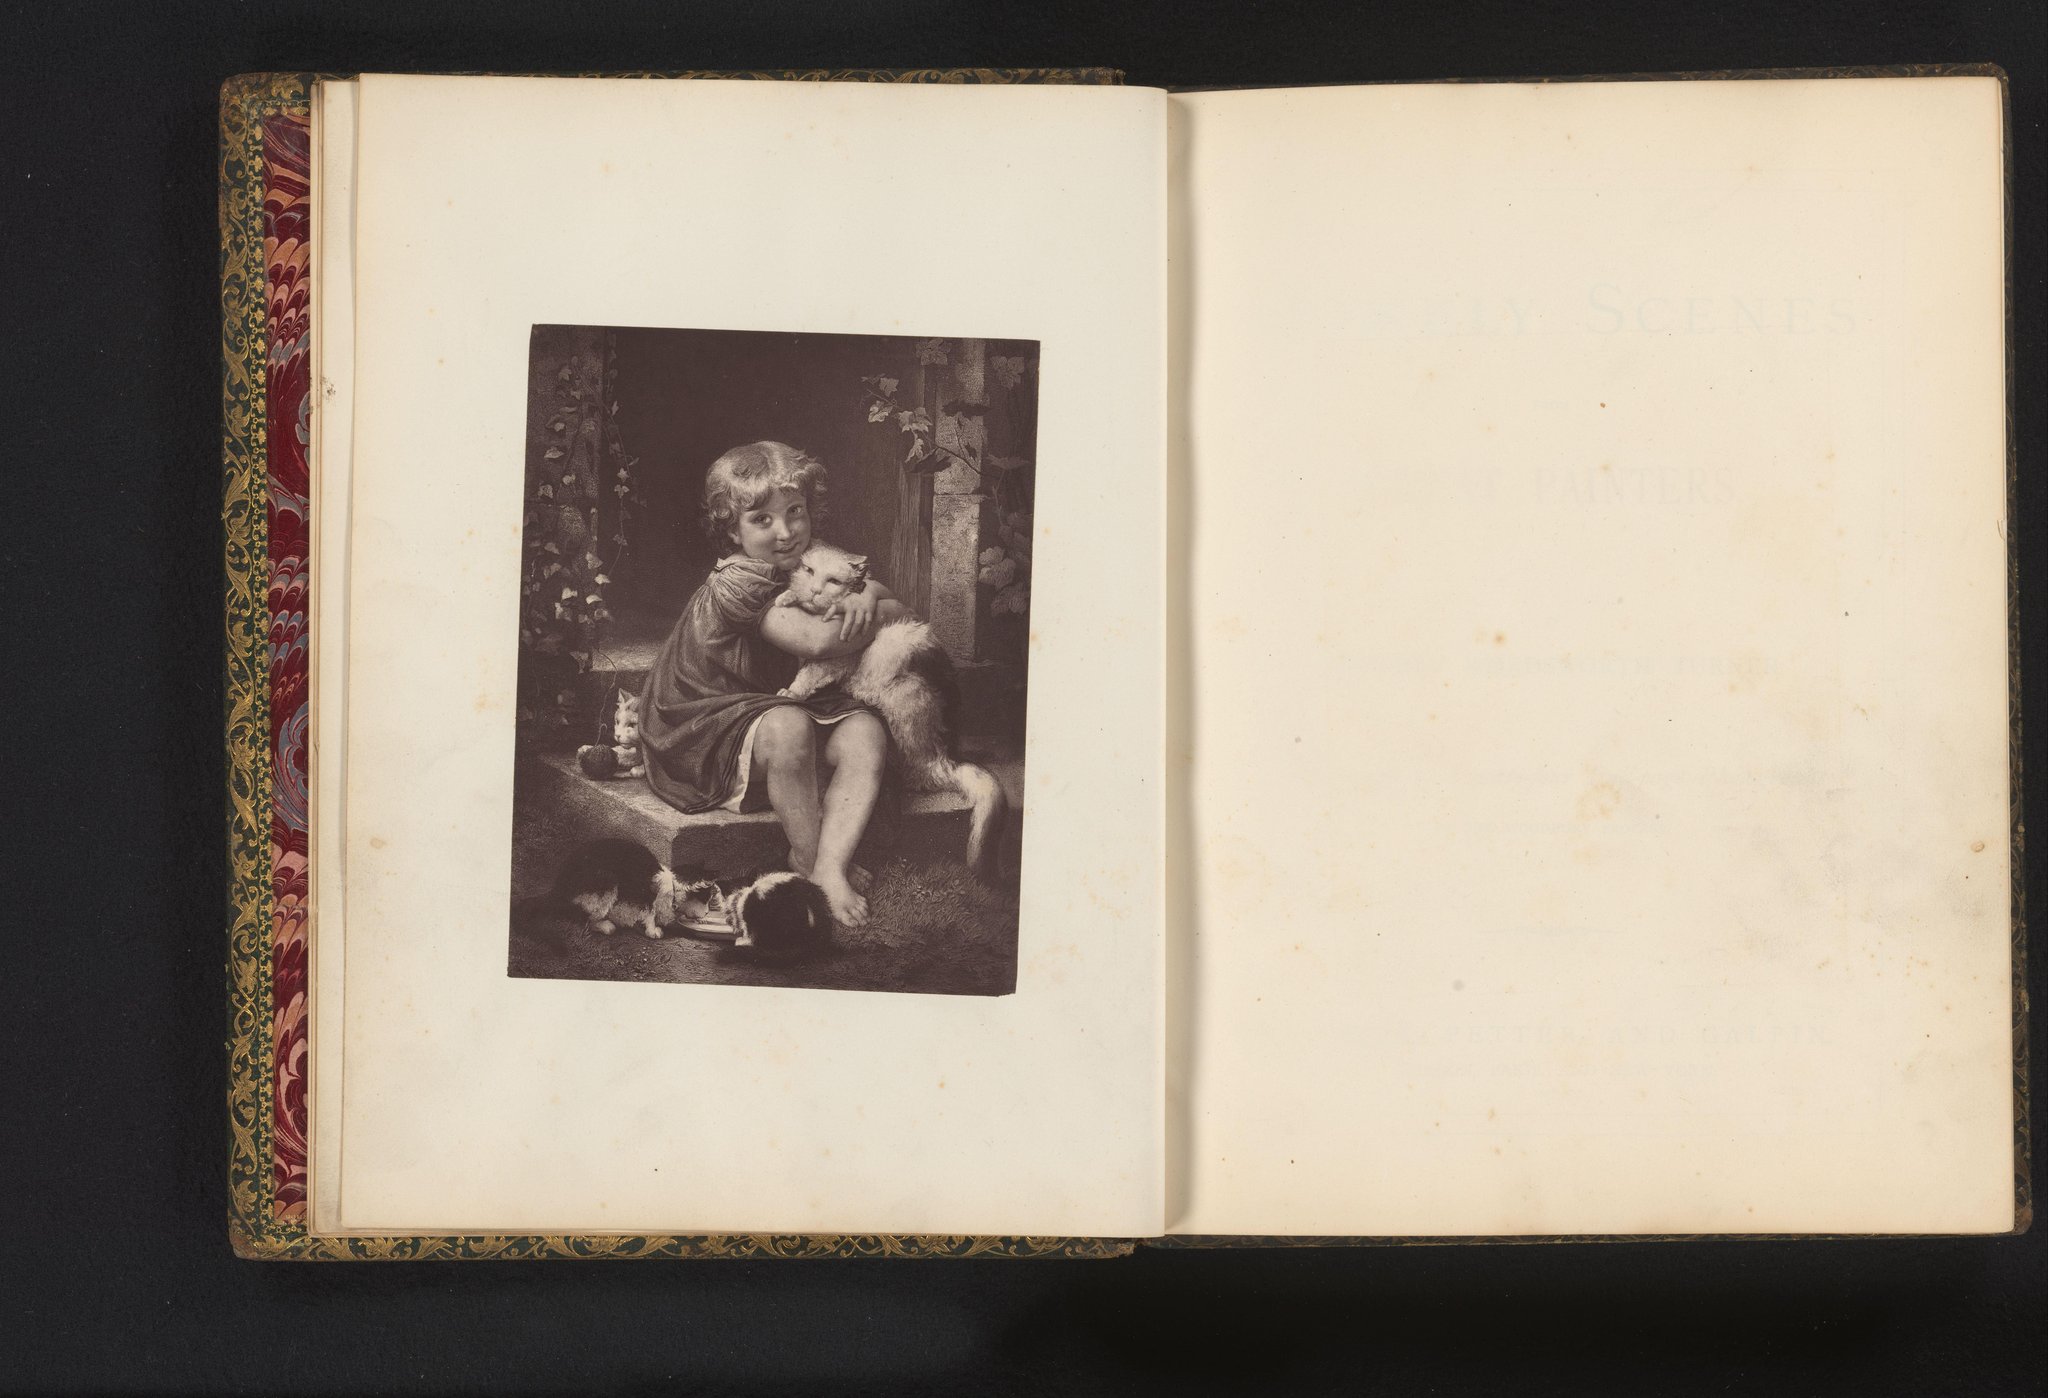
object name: photomechanical print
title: Fotoreproductie van een gravure naar het schilderij The kittens door Franz Meyerheim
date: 1866-1871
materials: paper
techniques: woodburytype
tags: cat, mother and baby or young child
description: Prent op derde ongenummerde pagina voor titelpagina.